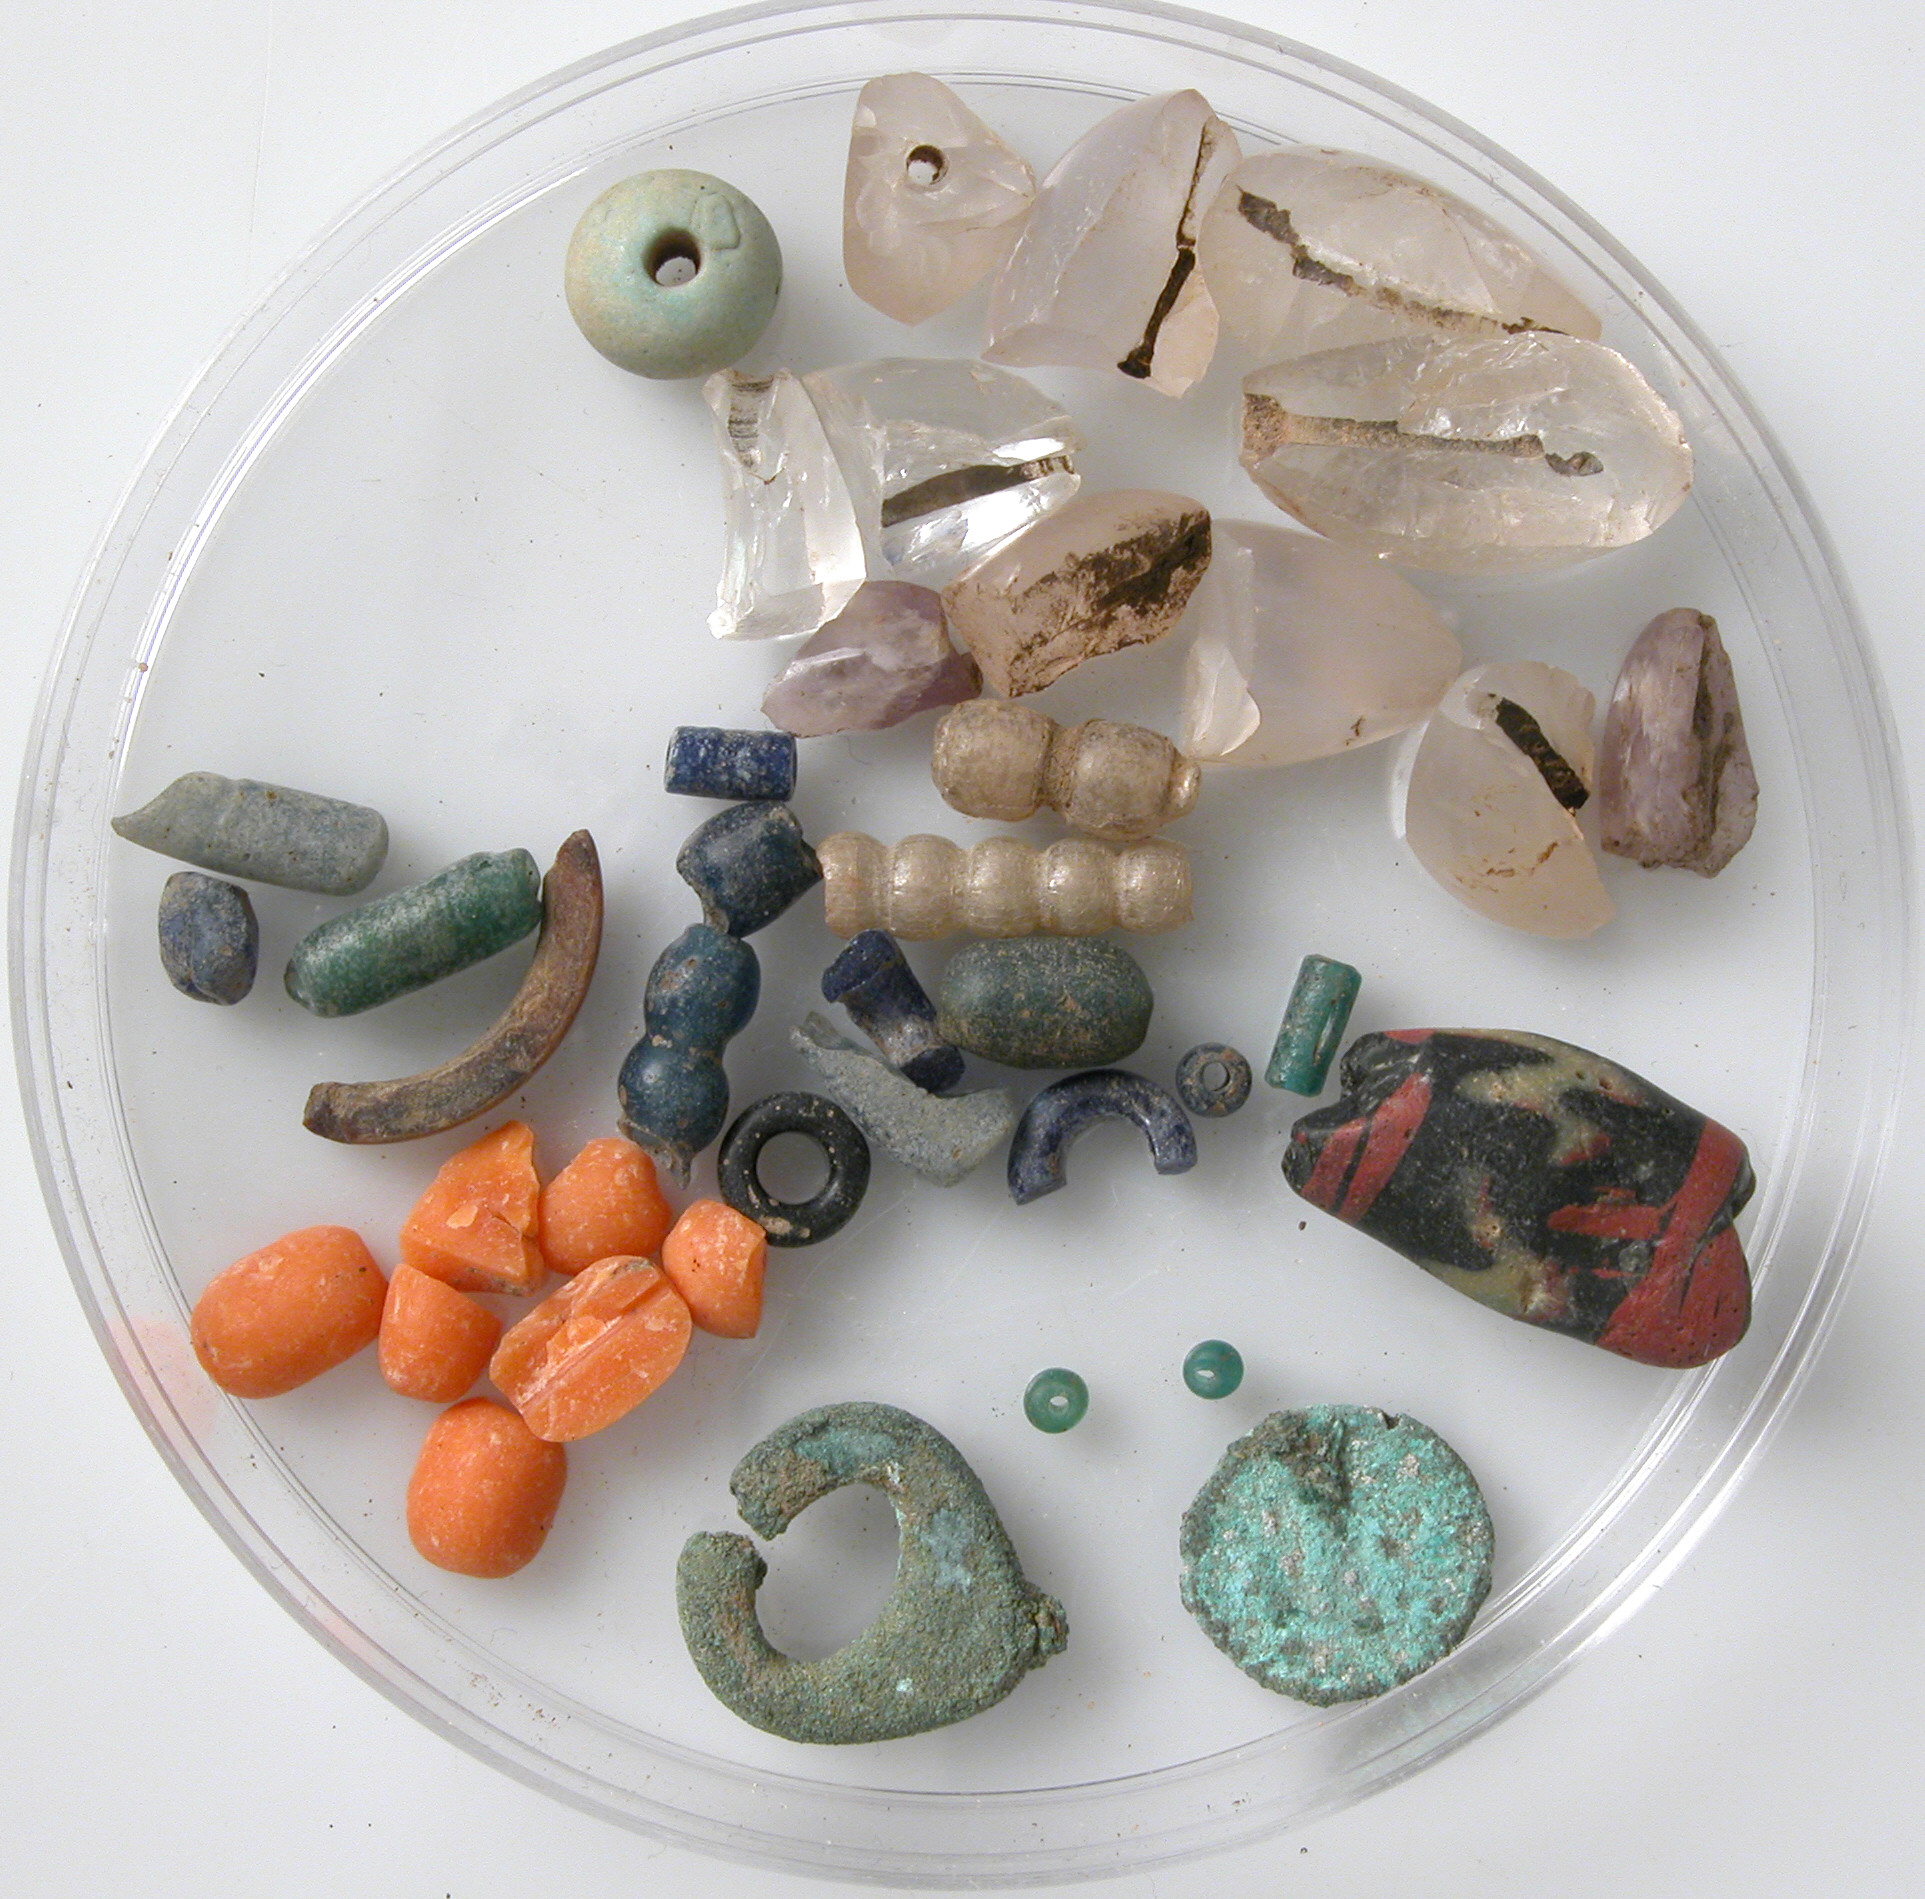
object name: bead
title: Beads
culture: coptic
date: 301-700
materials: copper alloy, coral, glass, quartz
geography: egypt